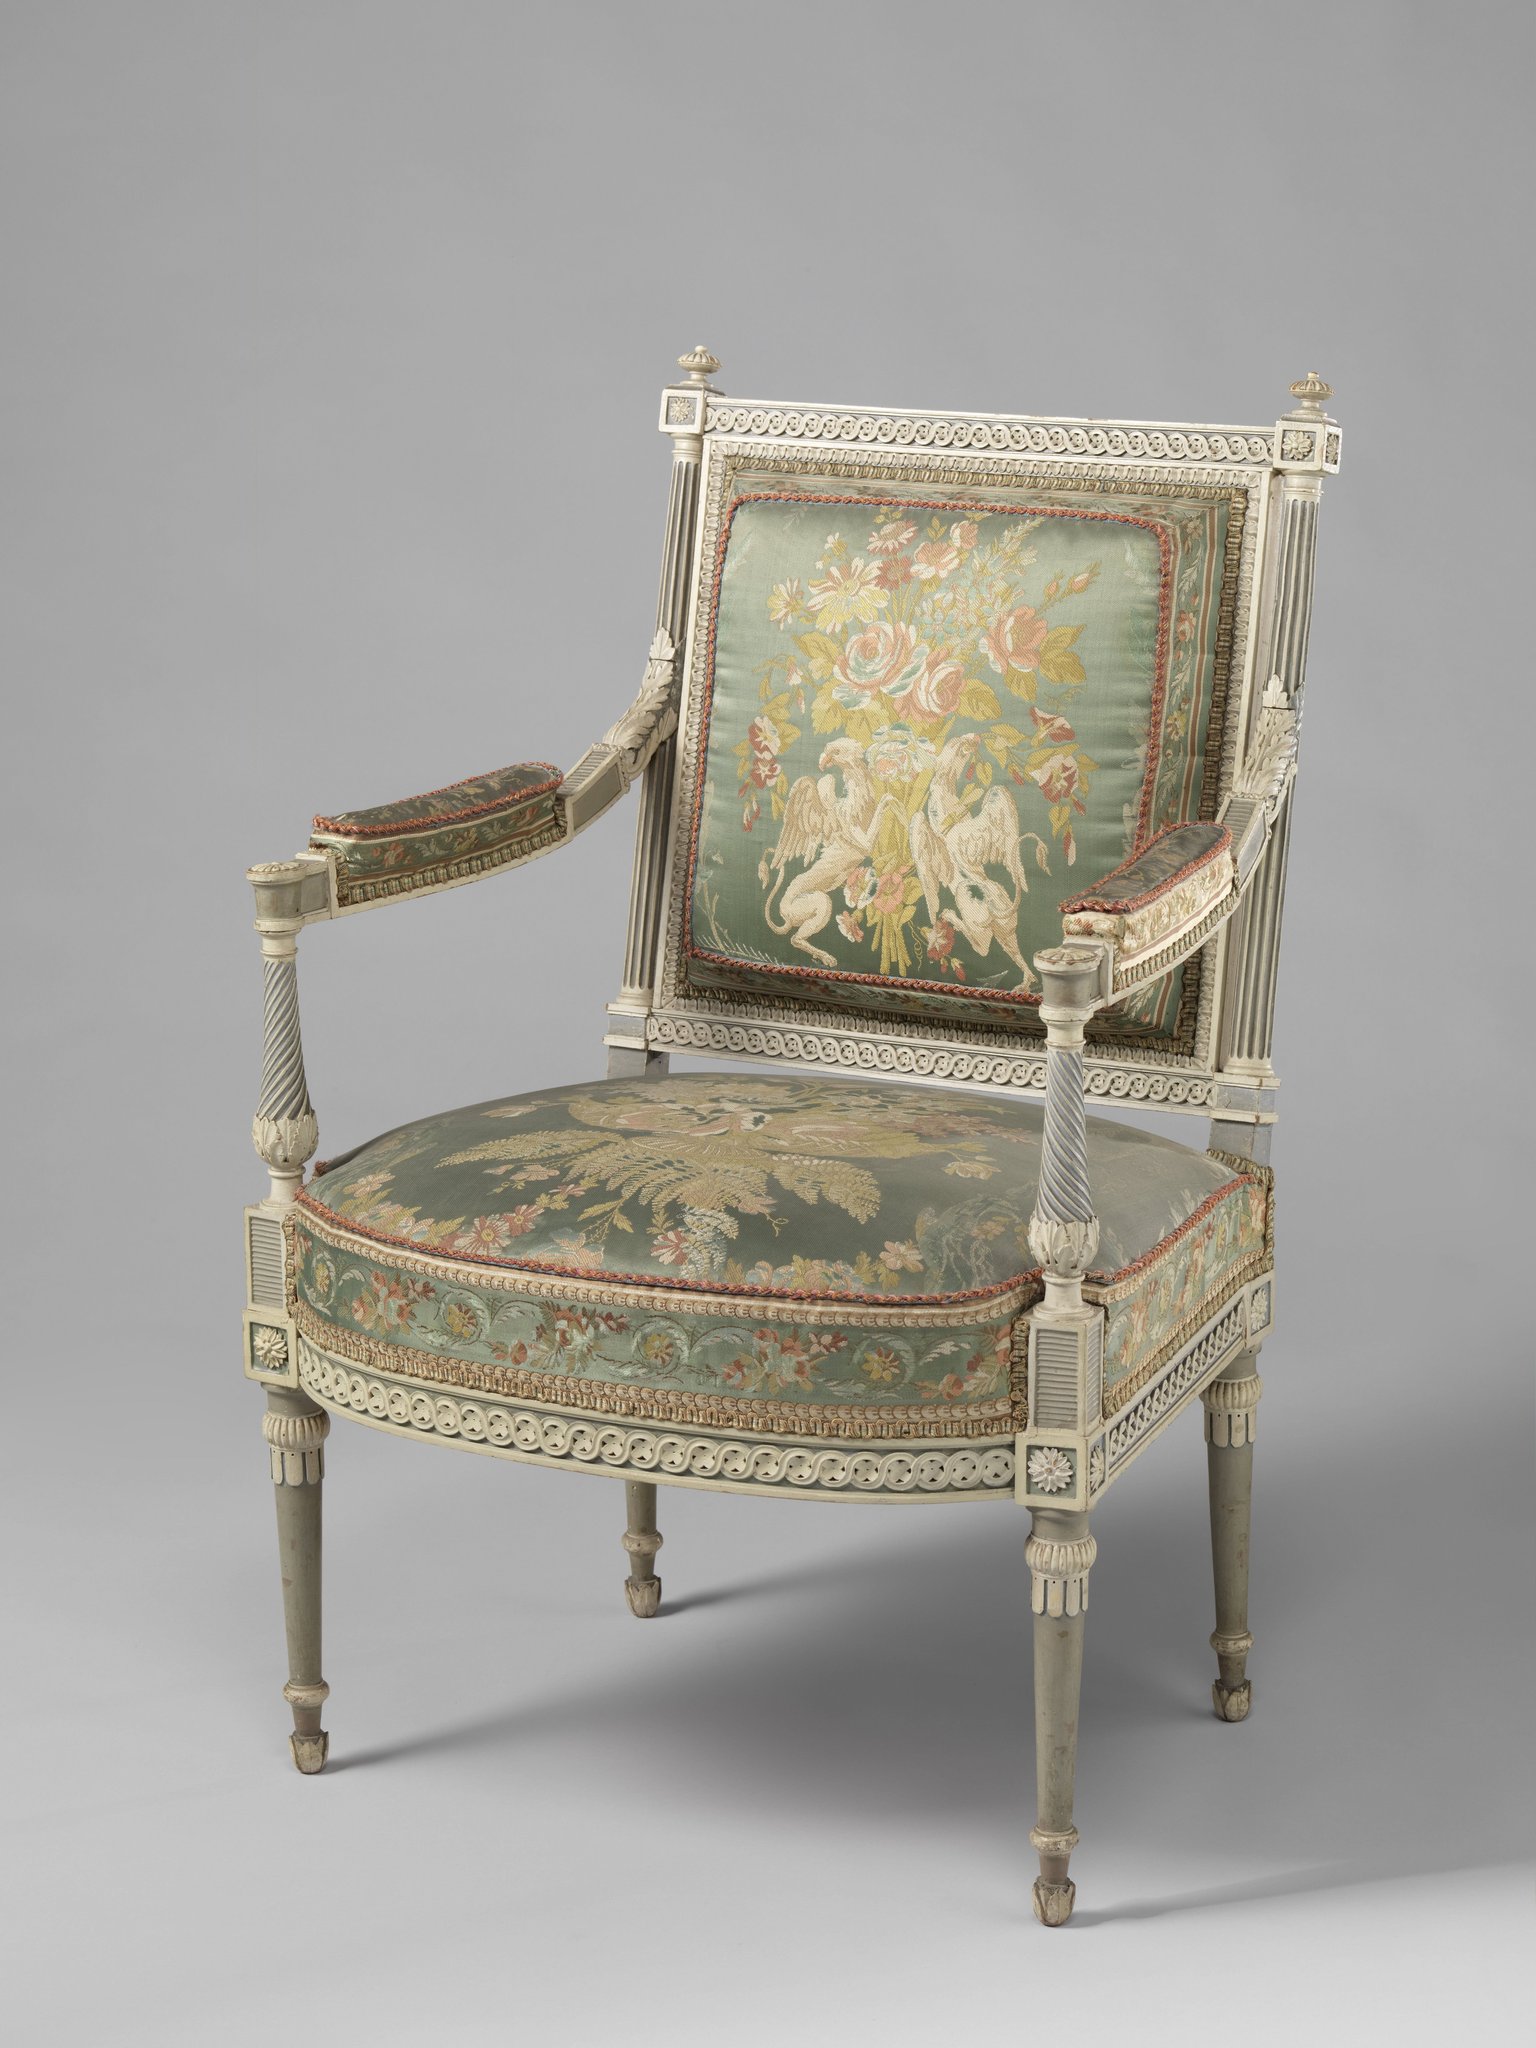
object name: suite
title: Armstoel Kops-ameublement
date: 1793-1795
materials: wood, paint, silk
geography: netherlands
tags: griffin (lion/eagle); 'griffo' (ripa), flowers ~ ornament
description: Beklede armstoel uit het Kops-ameublement, van wit en blauwgrijs beschilderd beukenhout. De zitregels en dorpels van het rugraam tonen gestoken vlechtband met rozetten. Vaasvormige stutten met geslingerde cannelures steunen de armleggers met kussens, die met een acanthusblad in de Toscaanse zuilen van het rugraam overlopen. De bekleding toont op lichtblauwe satijnen grond florale motieven, op de rug gehouden door griffioenen. Besteld voor pand Nieuwe Gracht 74, Haarlem. Zie: BK-15614, 15615-a/p, 15616-a/b.